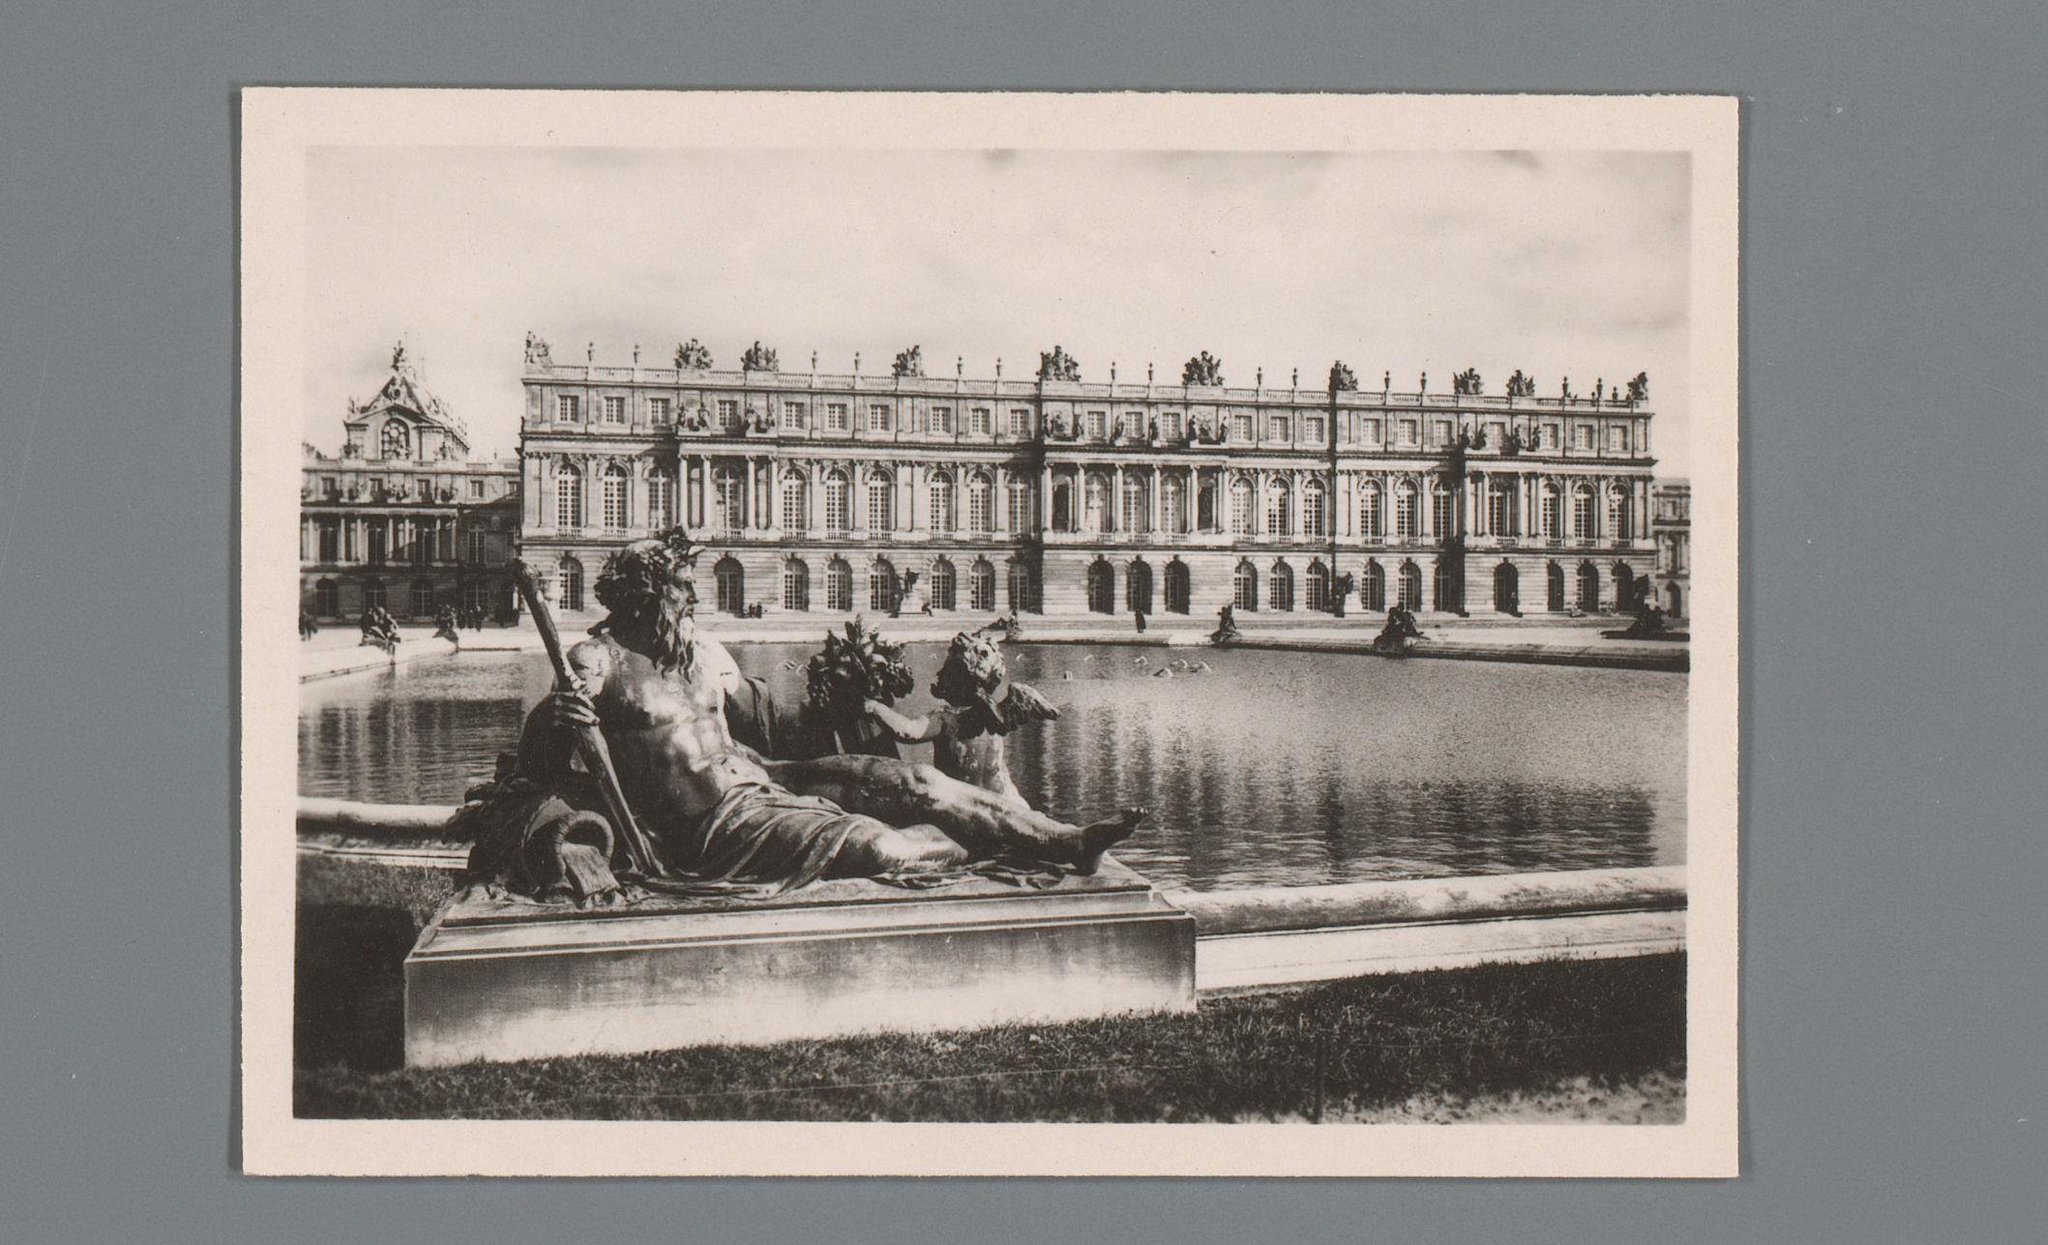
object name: photograph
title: Vue sur la Terrasse / View on the Terrace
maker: Anonymous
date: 1900-1920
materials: paper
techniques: gelatin silver print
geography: versailles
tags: palace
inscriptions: number: ‘4’